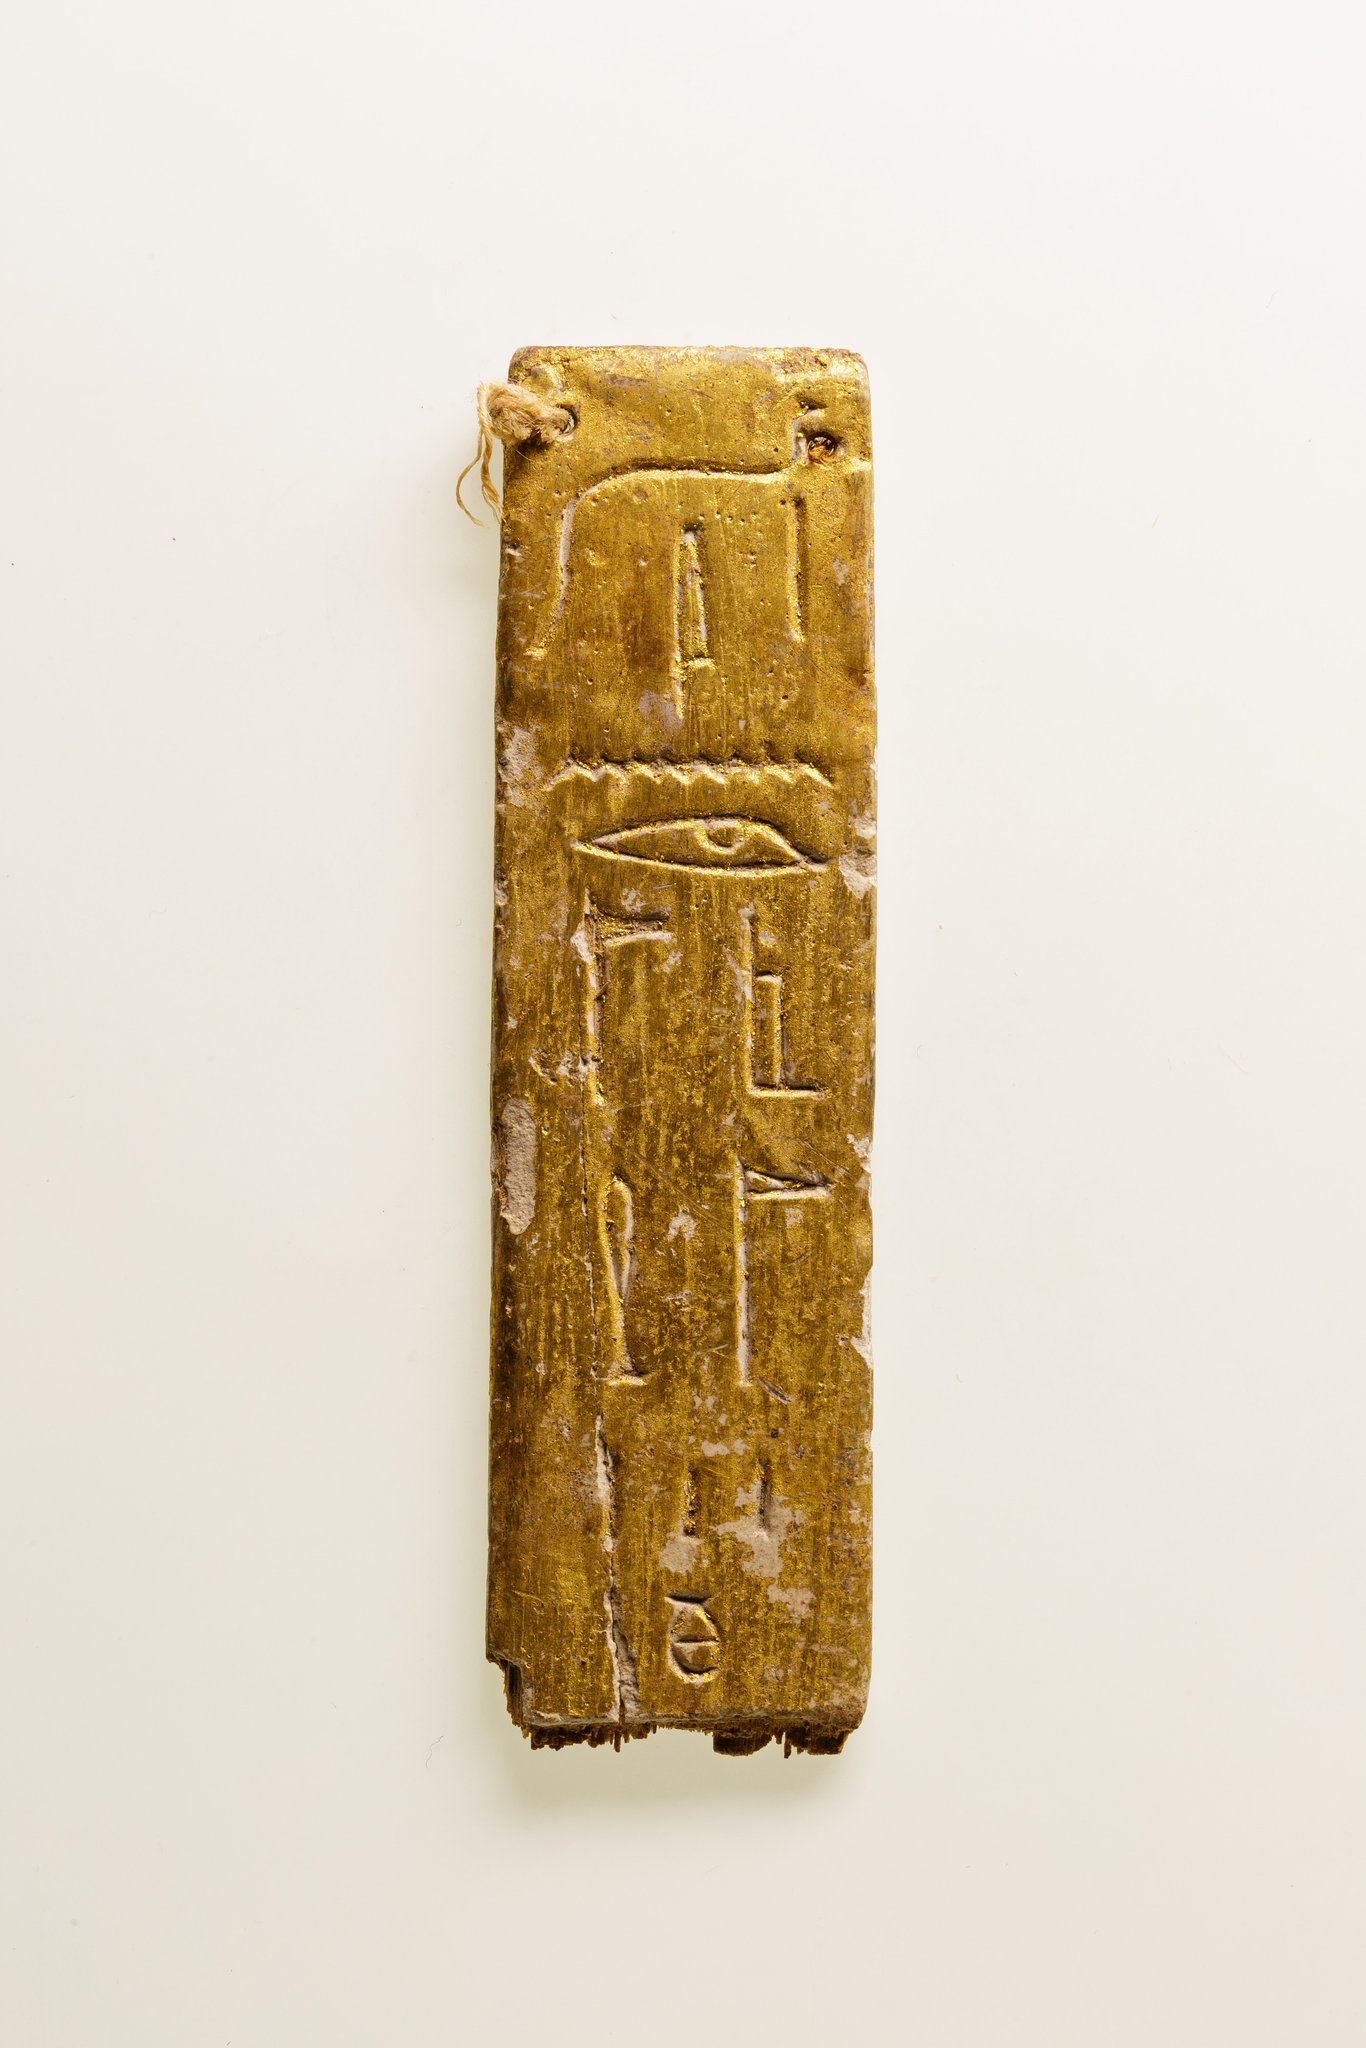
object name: furniture inlay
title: Tablet Amulet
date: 522-343 BCE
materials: gold leaf, wood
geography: egypt